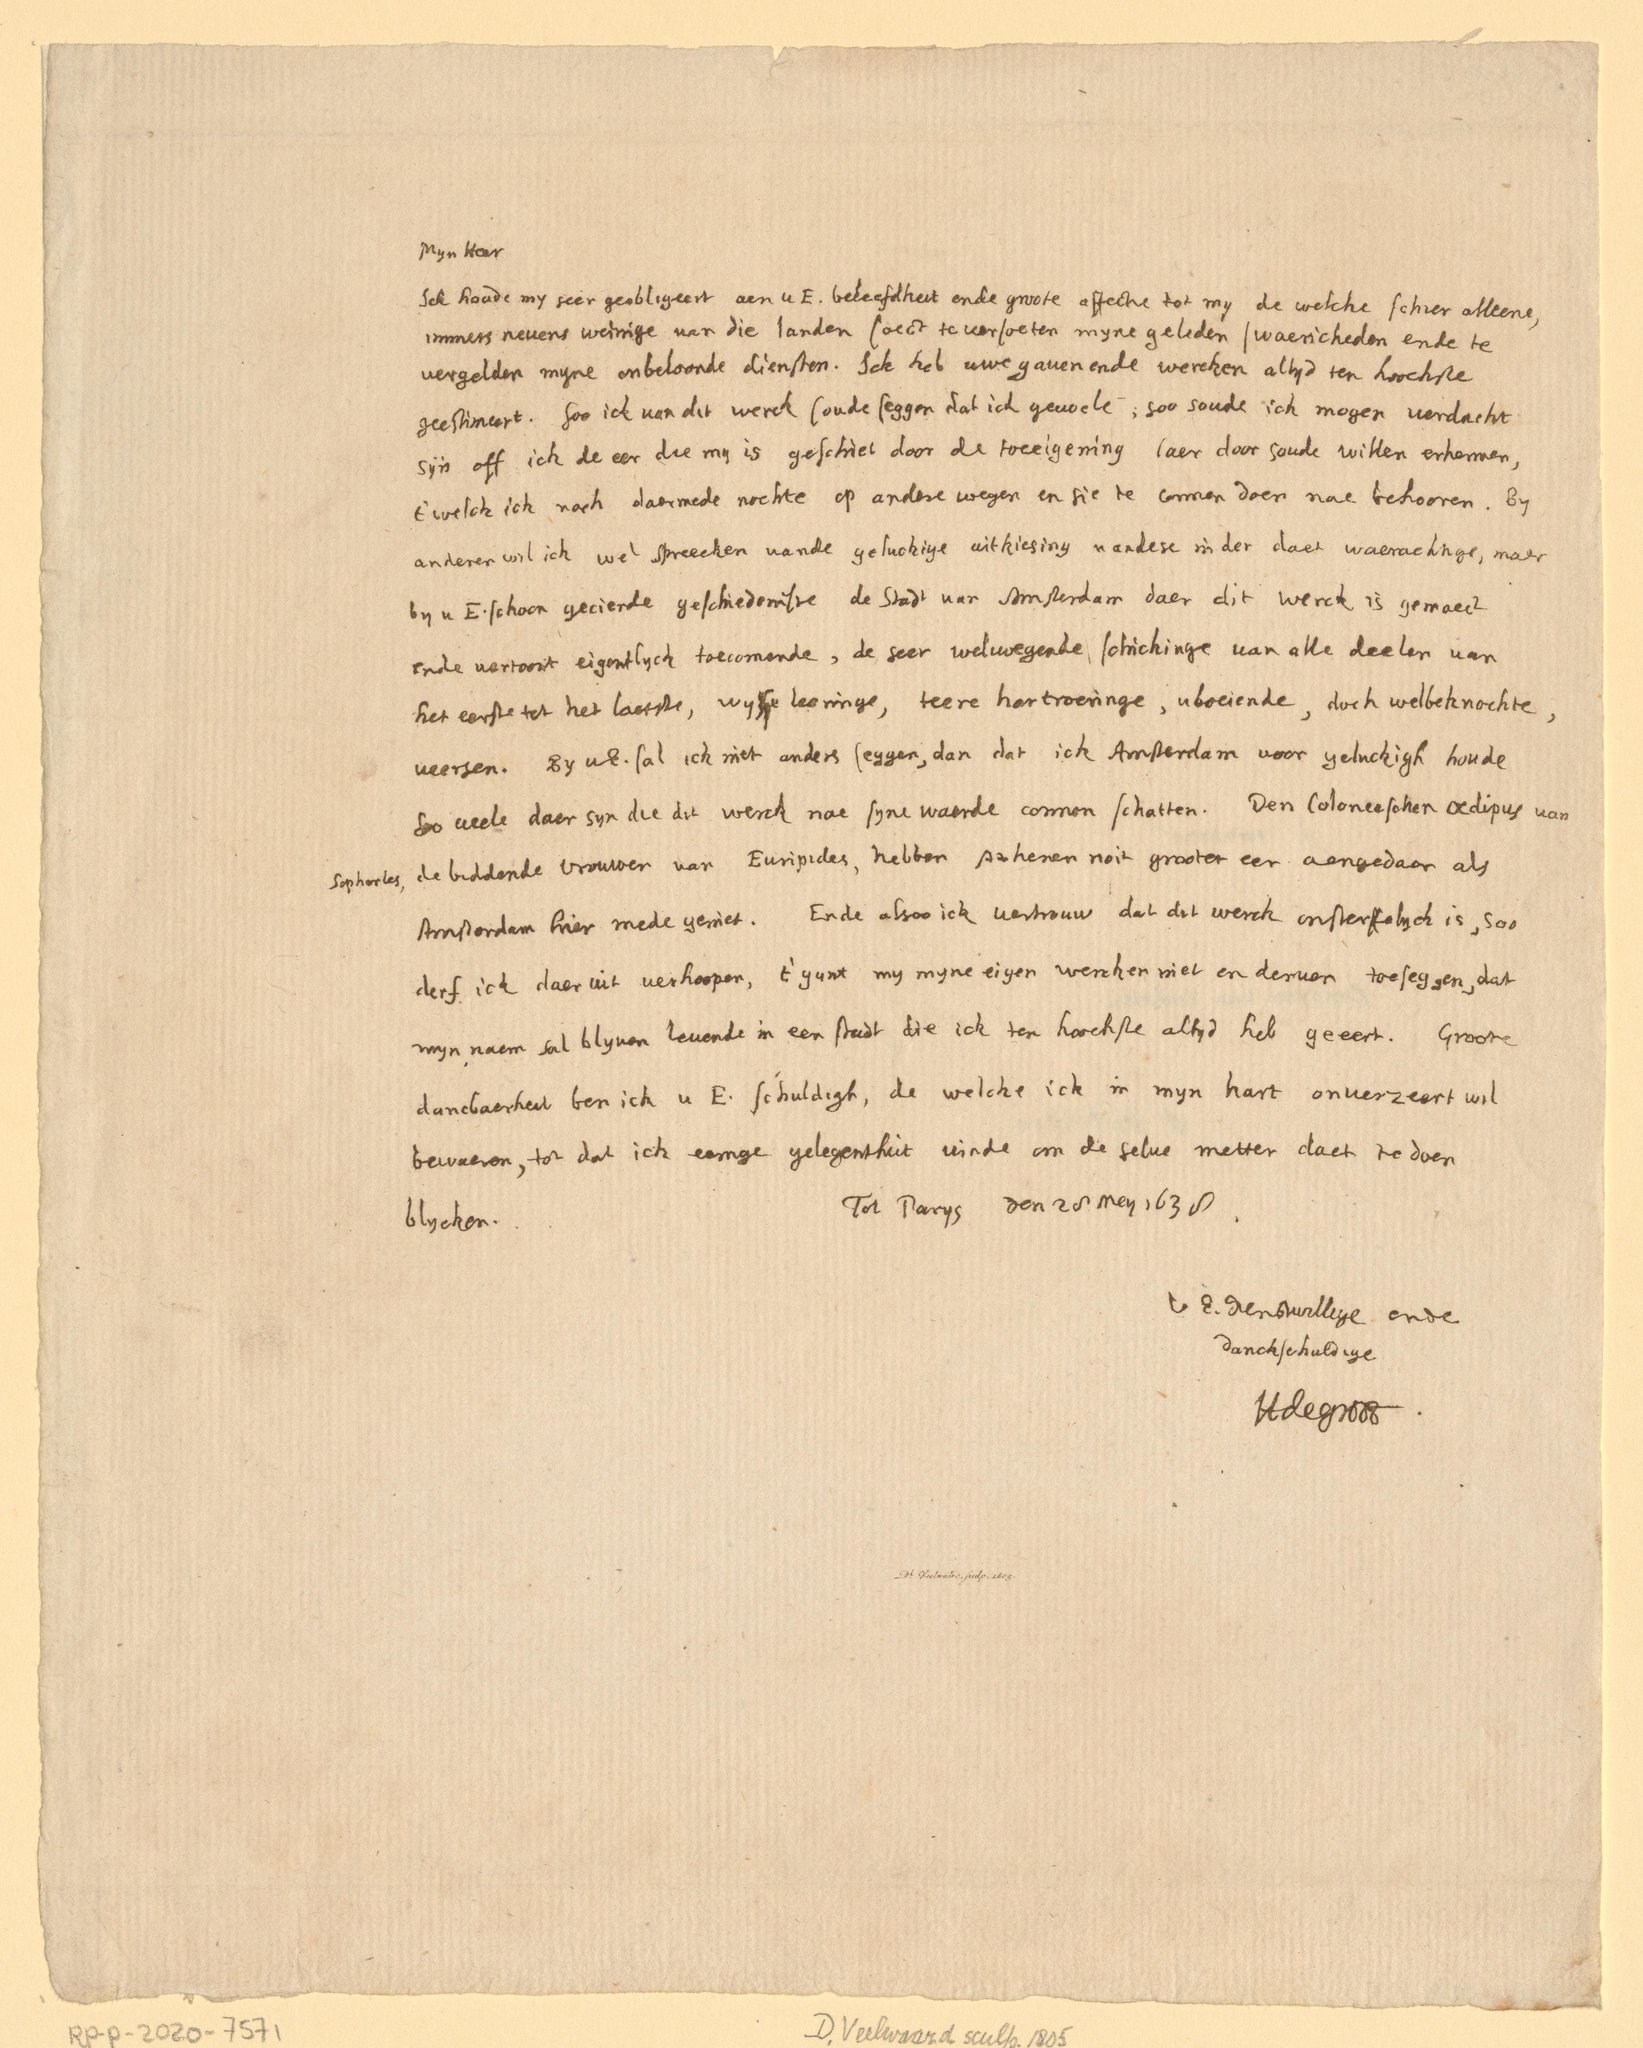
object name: print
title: Brief van Hugo de Groot aan Joost van den Vondel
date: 1805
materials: paper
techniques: etching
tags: delft, hugo de groot, cologne, joost van den vondel, portrait of a writer, letter, envelope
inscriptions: : ‘A monheer/ Monsieur van Vondelen/ A Amsterdam’